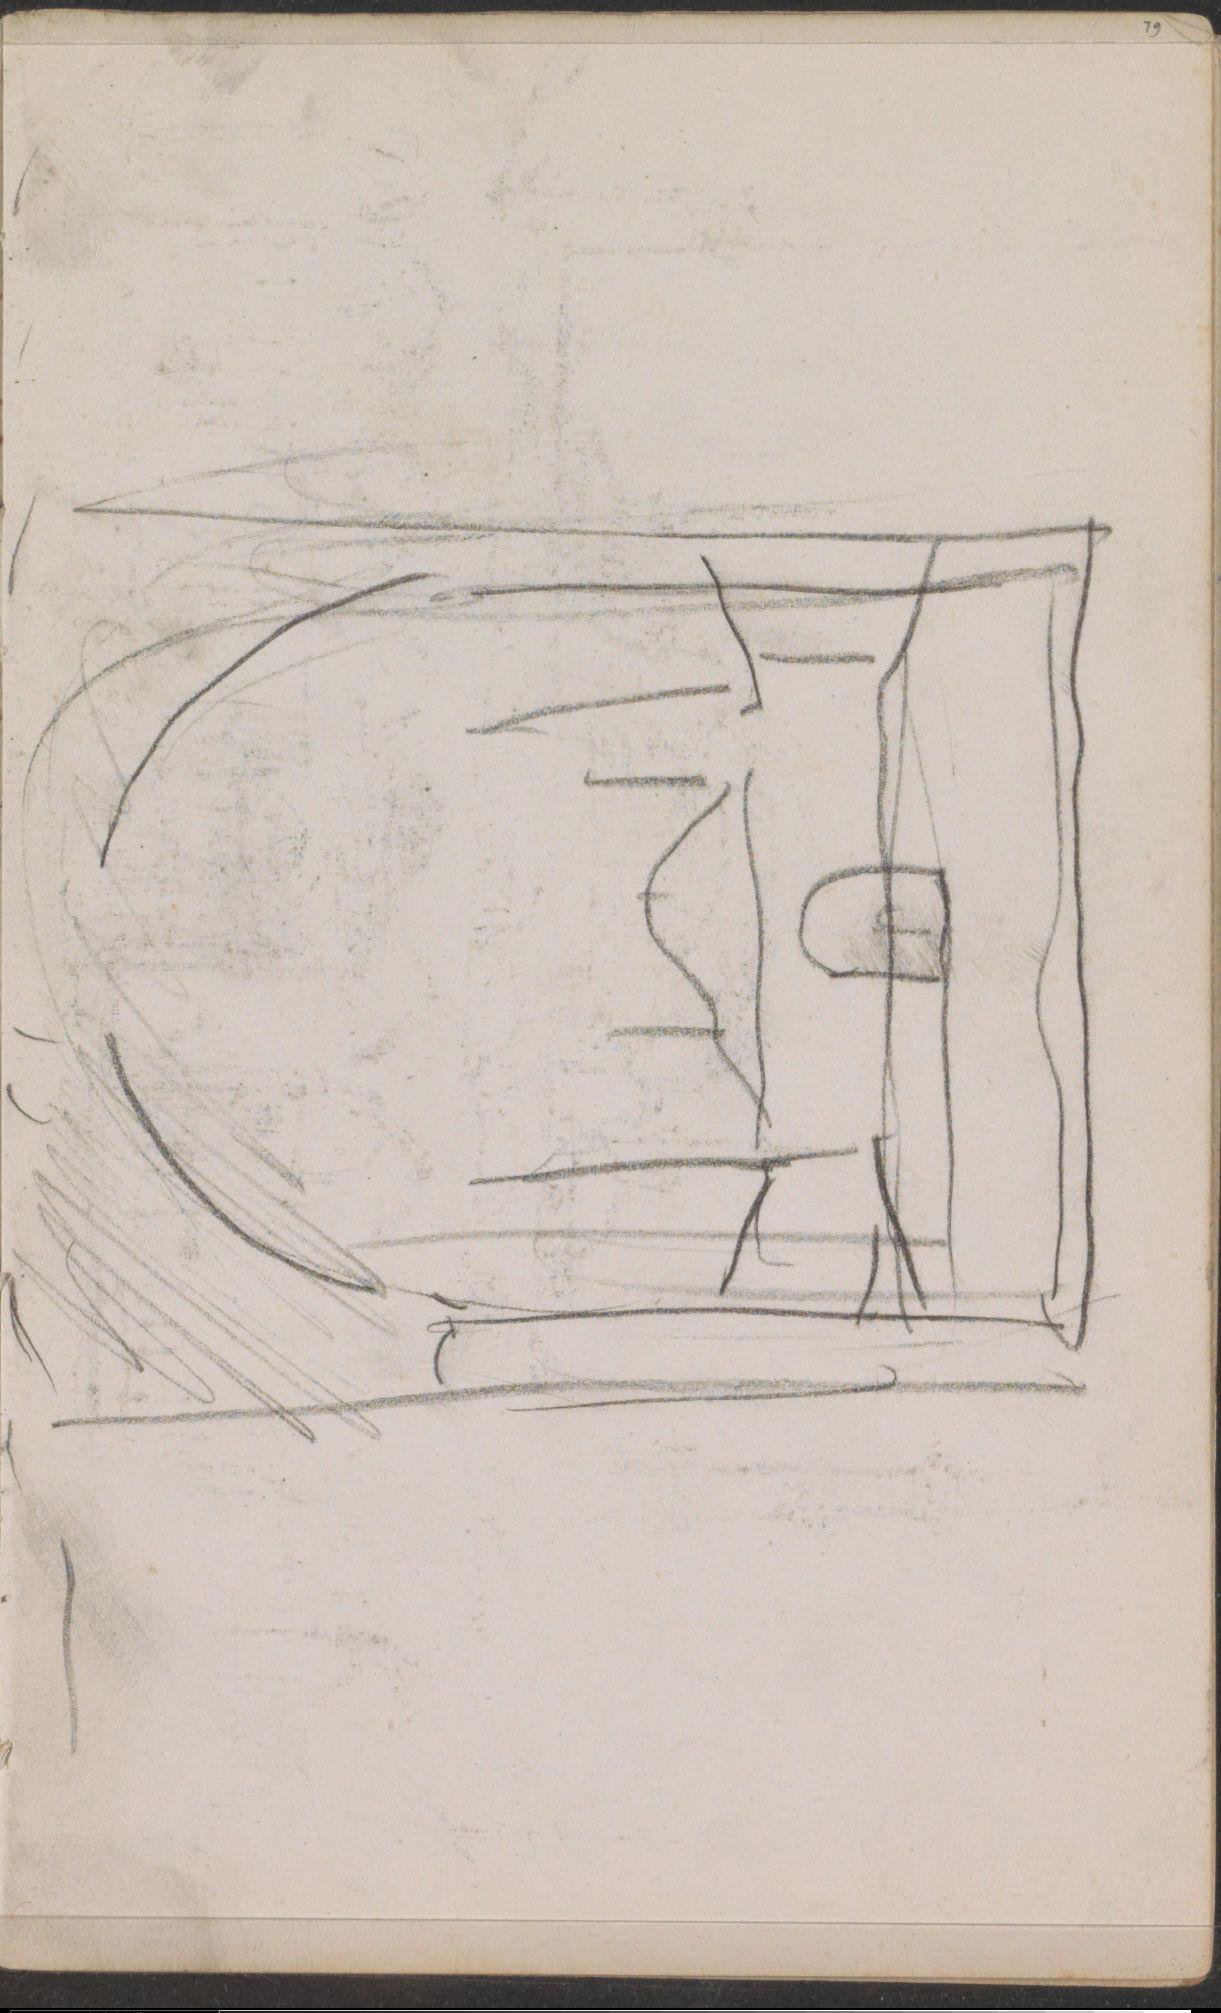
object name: sketchbook leaf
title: Rondboog met een gezicht op een moskee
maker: marius bauer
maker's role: draughtsman, print maker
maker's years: 1867-1932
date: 1896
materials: chalk, paper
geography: istanbul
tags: arch, archivolt ~ architecture, courtyard, temple, shrine ~ islam, mohammedanism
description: Mogelijk een vereenvoudigde studie van de tekening van de Sultan Ahmetmoskee op pagina 78.